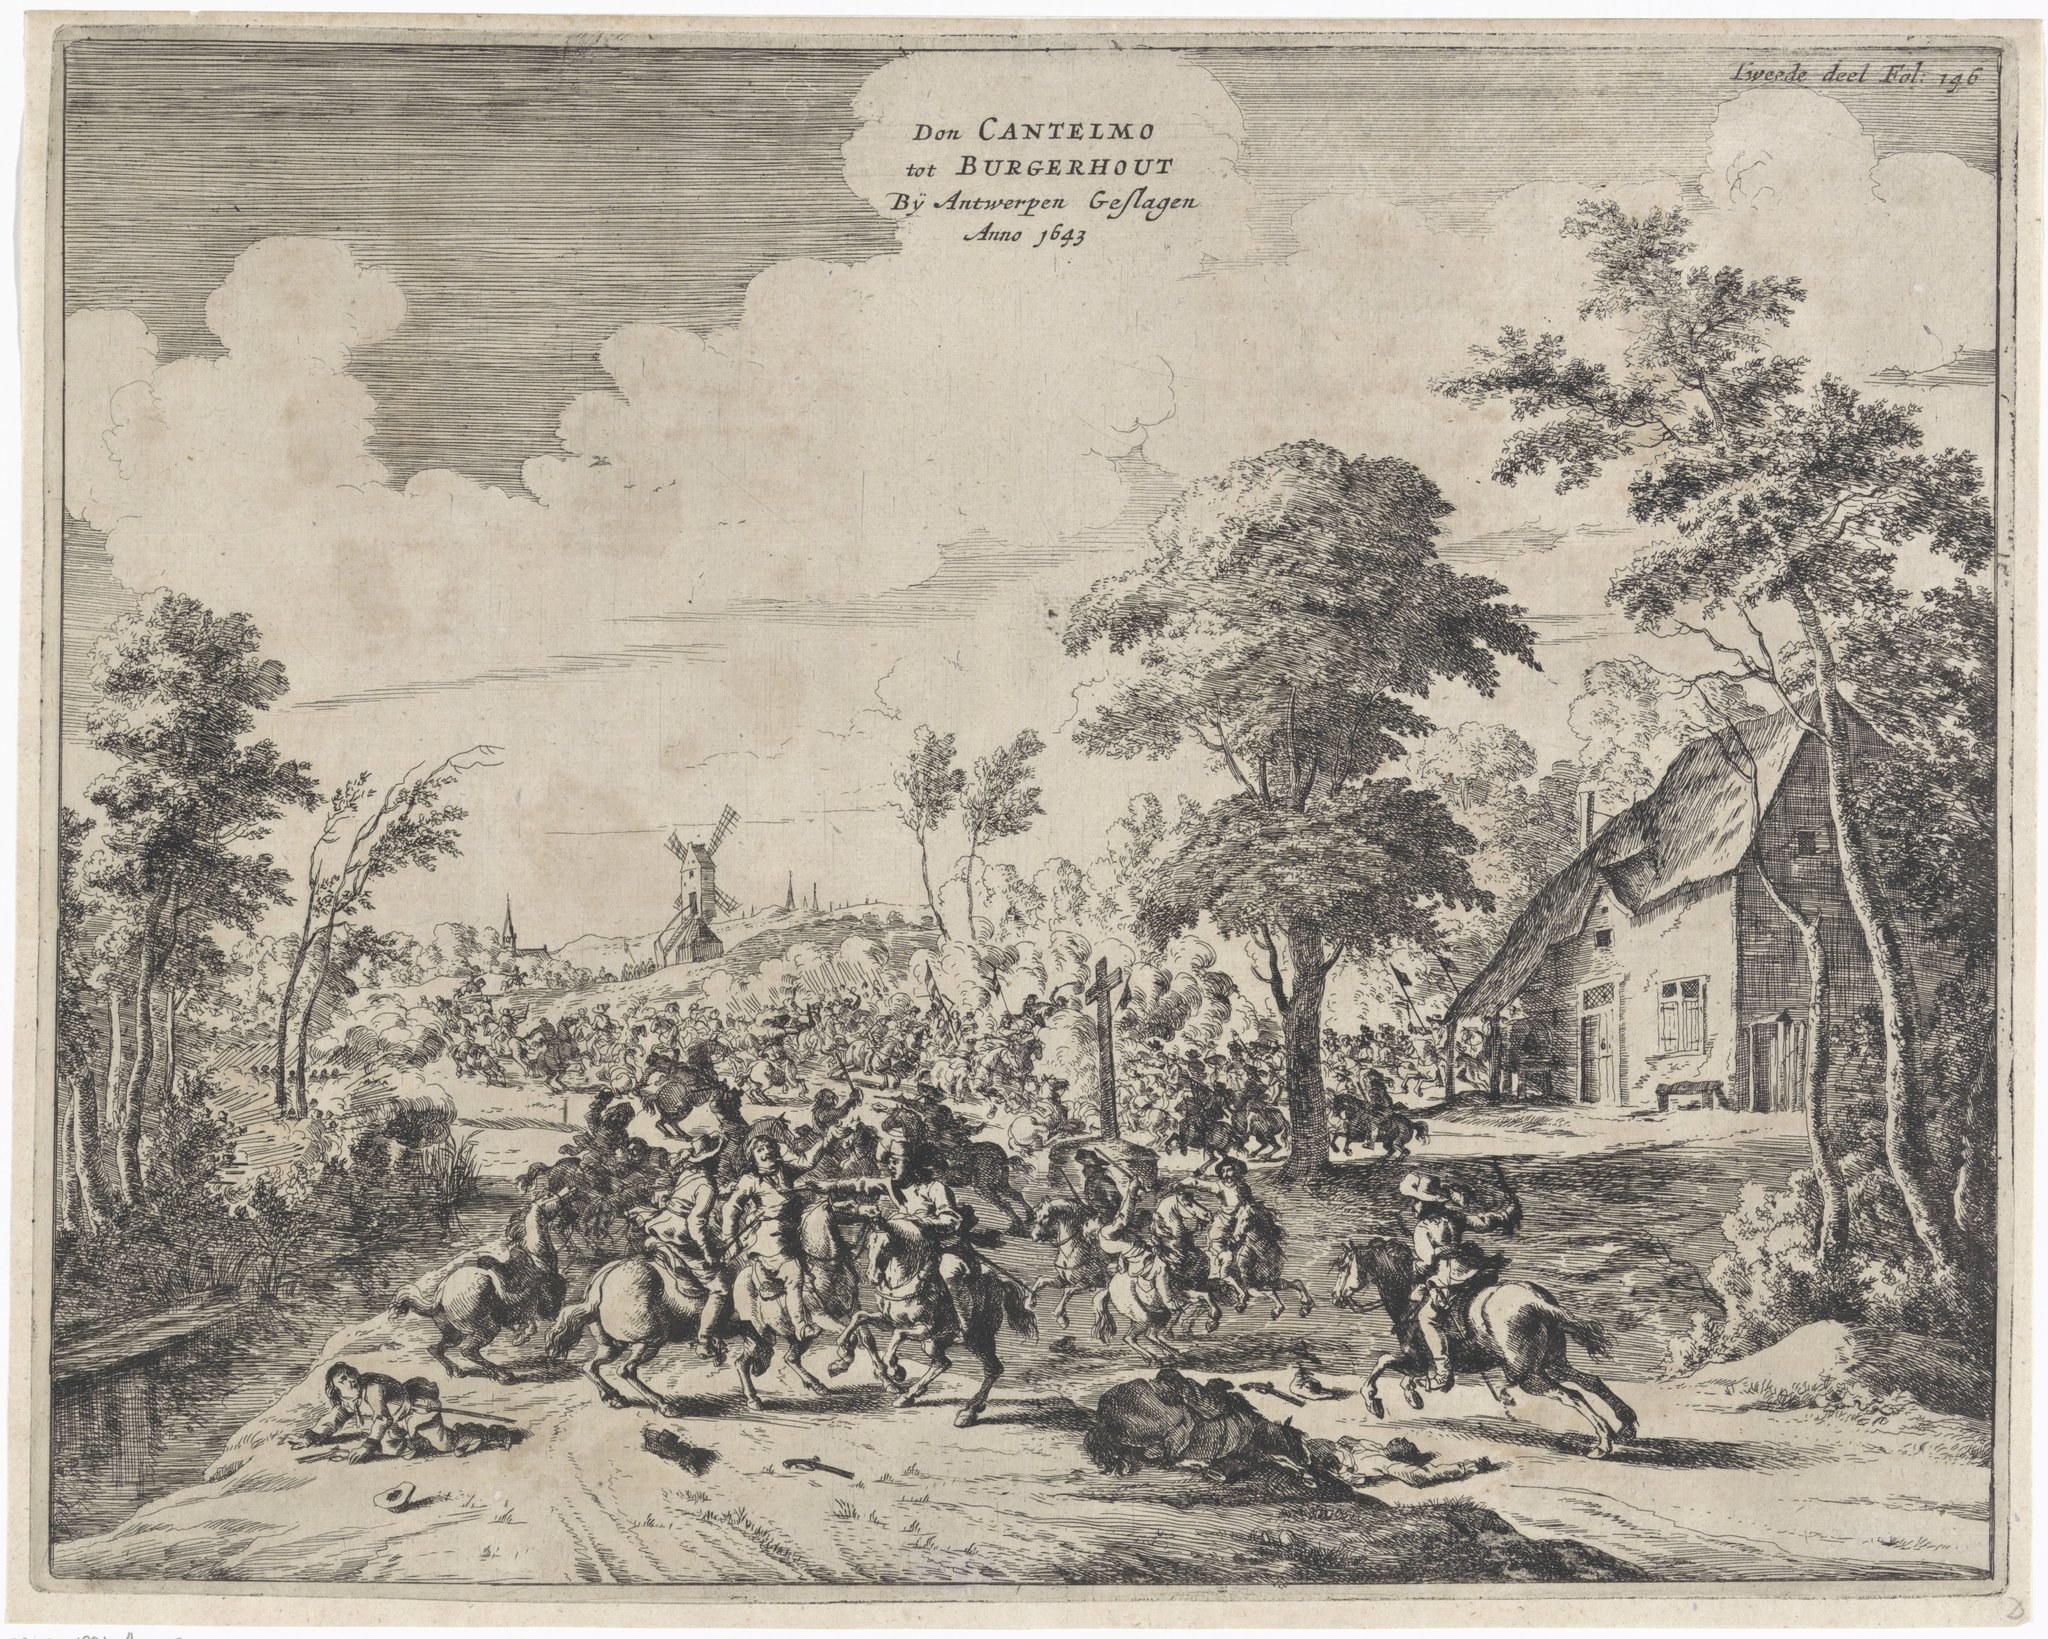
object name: book illustration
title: Spanjaarden onder Don Cantelmo bij Borgerhout verslagen, 1643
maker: dirk stoop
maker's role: draughtsman, painter, print maker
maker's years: 1615-1686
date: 1651-1652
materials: paper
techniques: engraving, etching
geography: netherlands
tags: william ii (prince of orange), don andrea cantelmo, battle (+ land forces)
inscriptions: collector's mark: Lugt 2228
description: Prent gebruikt in: Commelin, Isaac. Frederick Hendrick van Nassauw prince van Orangien zyn leven en bedryf. Utrecht: Wed. Esdras Willemsz Snellaert en Gerrit Nieuwenhuysen, 1652, dl. 2, fol. 146. Kopie naar de prent in de uitgave van Jodocus Janssonius van 1651 (FMH 1872). Volgens Van der Kellen (zie Suppl.) is deze prent het origineel.